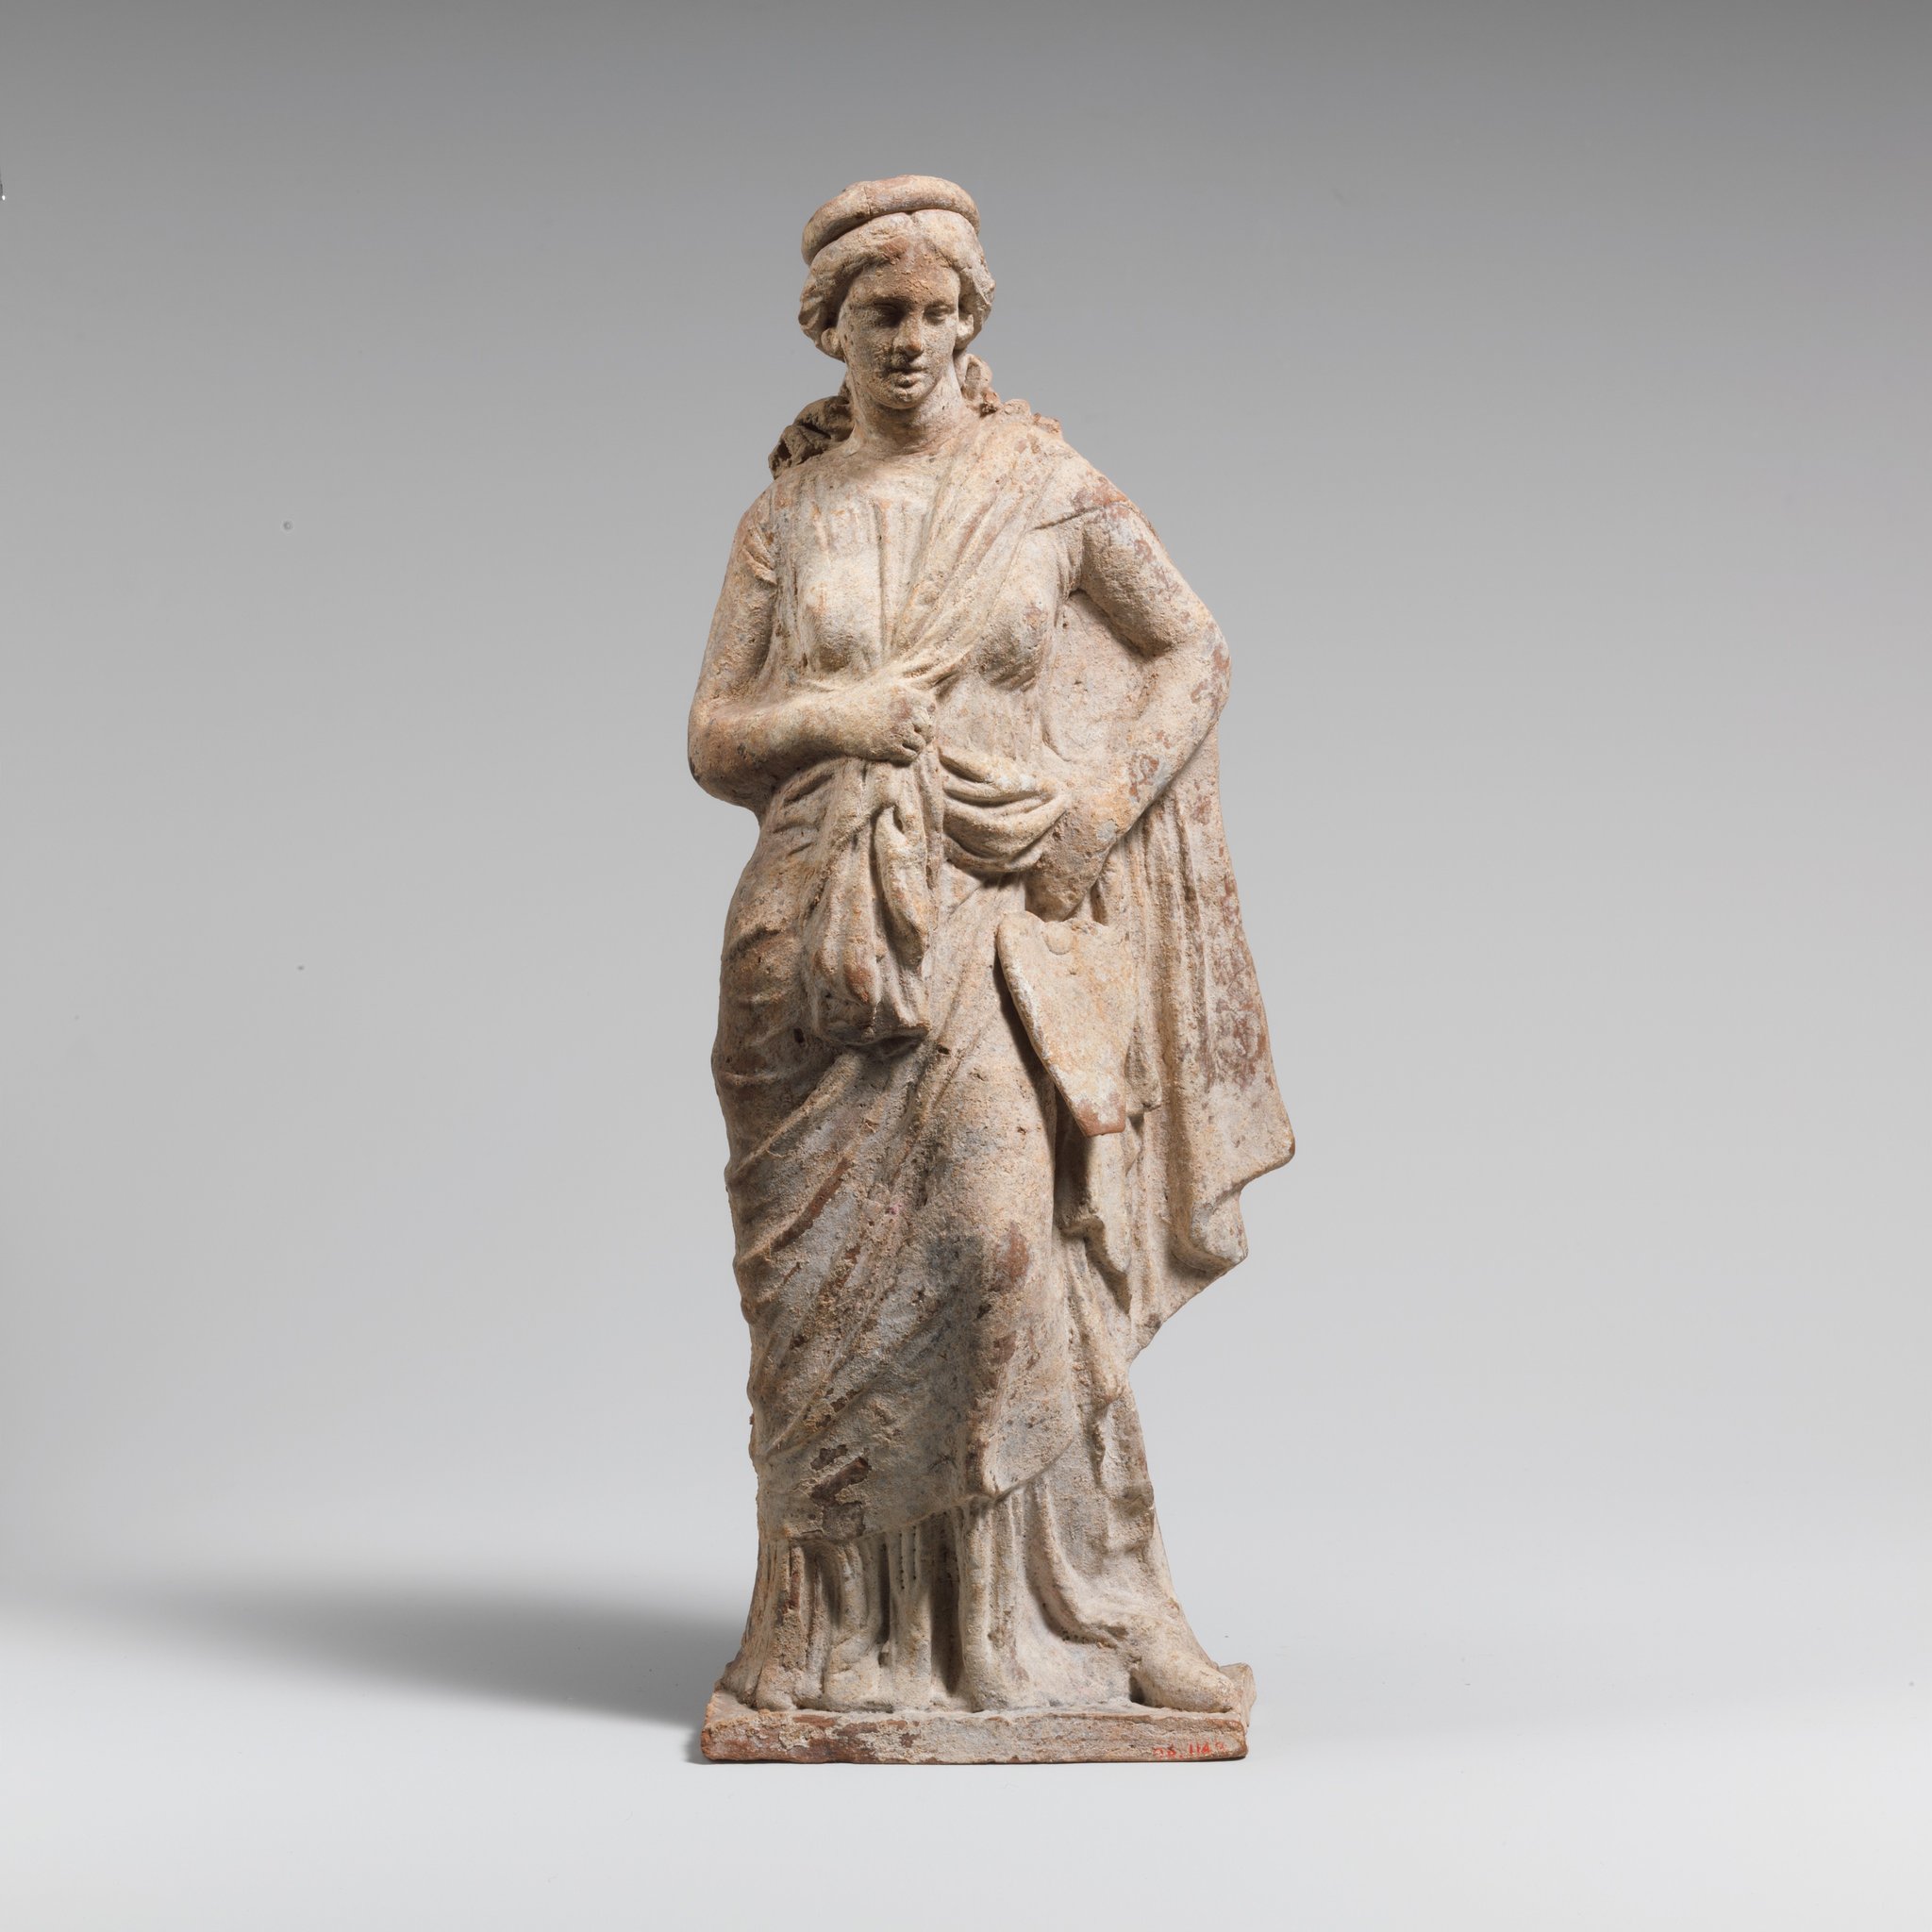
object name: statuette of a woman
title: Terracotta statuette of a woman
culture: greek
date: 200-101 BCE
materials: terracotta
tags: women